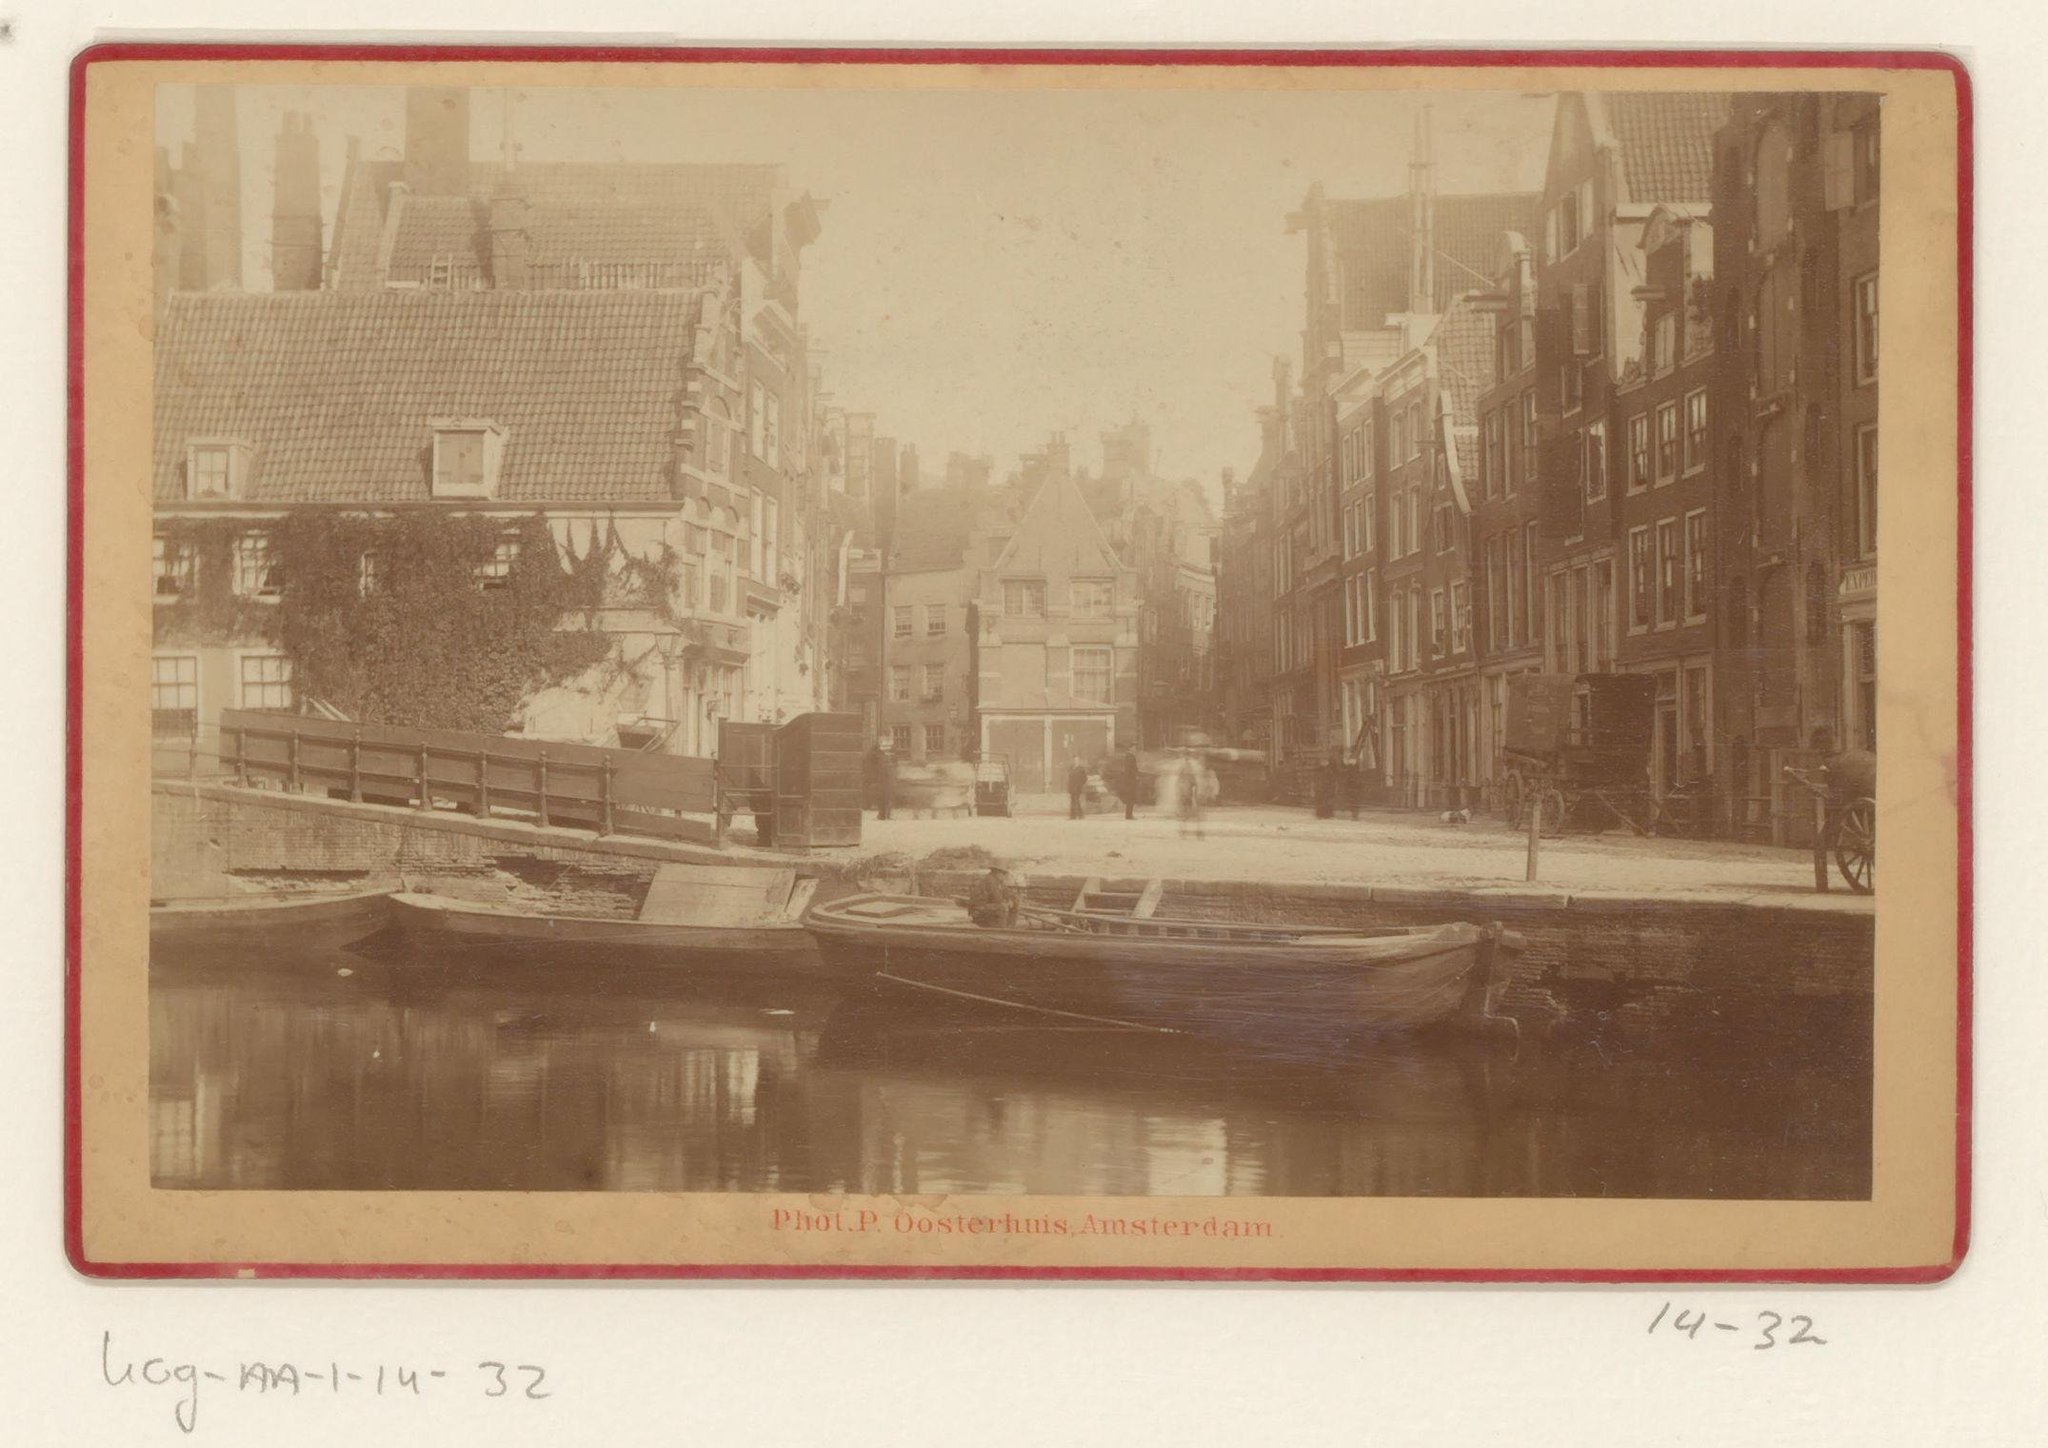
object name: cabinet photograph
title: Gezicht op de Nieuwezijds Kolk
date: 1881-1885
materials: cardboard, paper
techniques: albumen print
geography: amsterdam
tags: city-view in general; 'veduta', canal, the usual house or row of houses, street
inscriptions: : ‘Boekhandel van / G,H,L, Winkelhagen / 7. Raamsteeg 7. Amsterdam’, inscription: ‘N.Z. Kolk’, collector's mark: ‘14.32’ Lugt 1641b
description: Onderwerpsrubriek binnen de Atlas Amsterdam: Verhulststraat (Johannes), Viaducten, Vierwindenstraat, Vinkenbuurt, Vinkenpad, Vinkenstraat, Vischsteeg, Vliegendesteeg, Voetboogstraat, Volewijk, Vondelstraat, Voorburgwal (N.Z.).